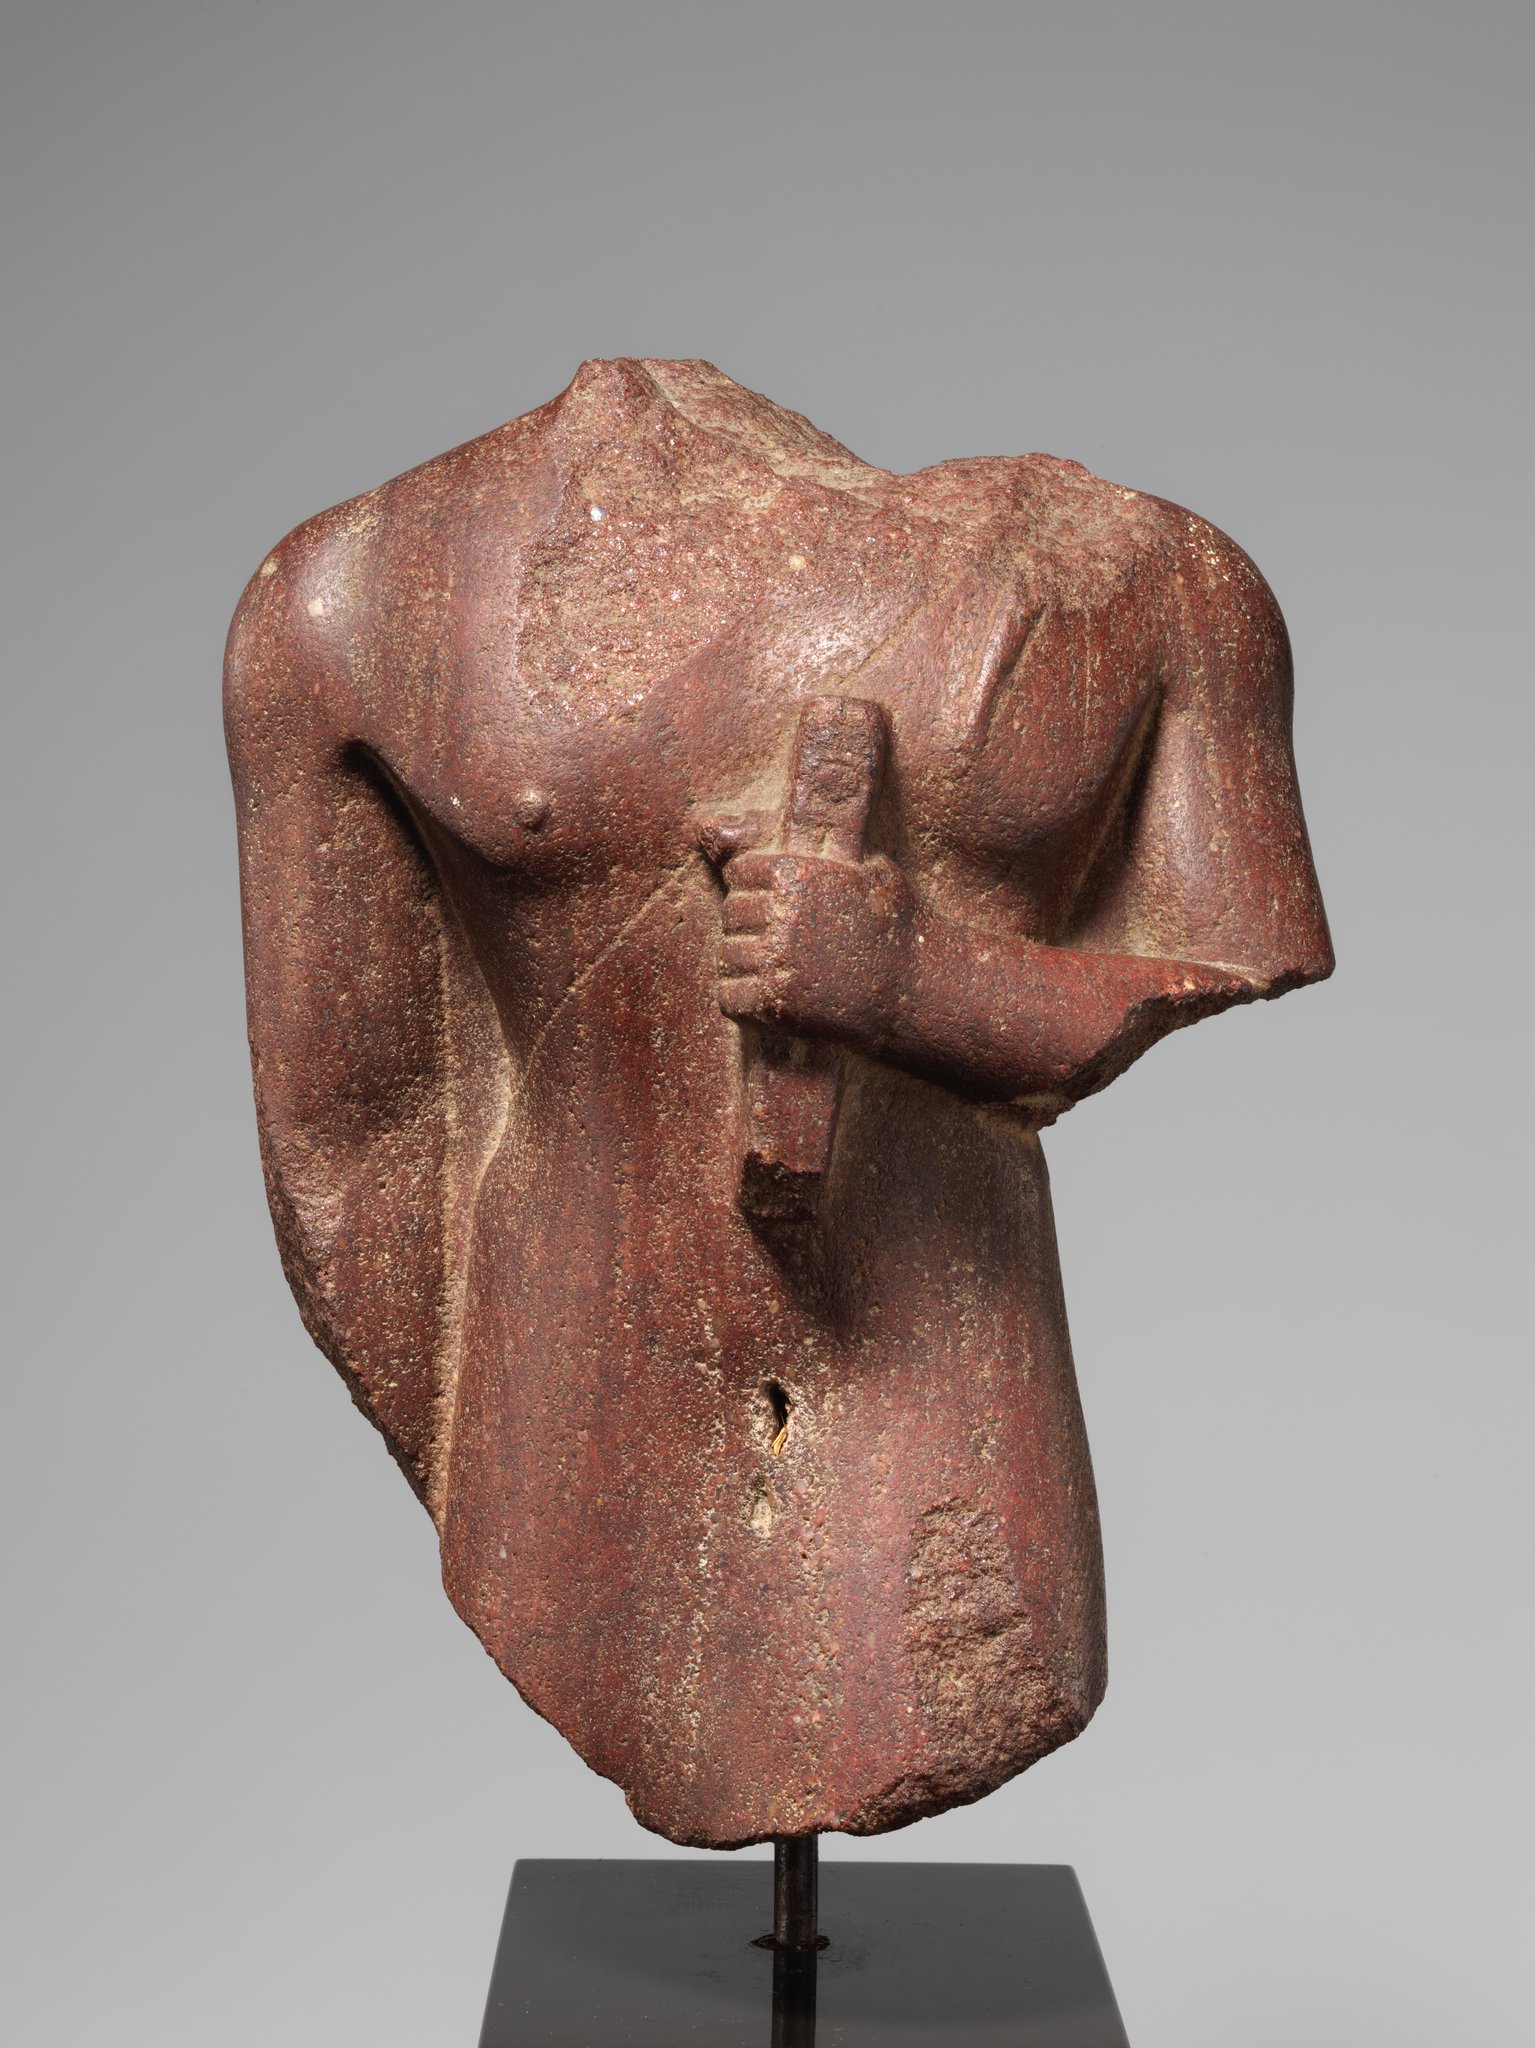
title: Statue of the Royal Treasurer Taruru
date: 760-664 BCE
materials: quartzite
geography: egypt